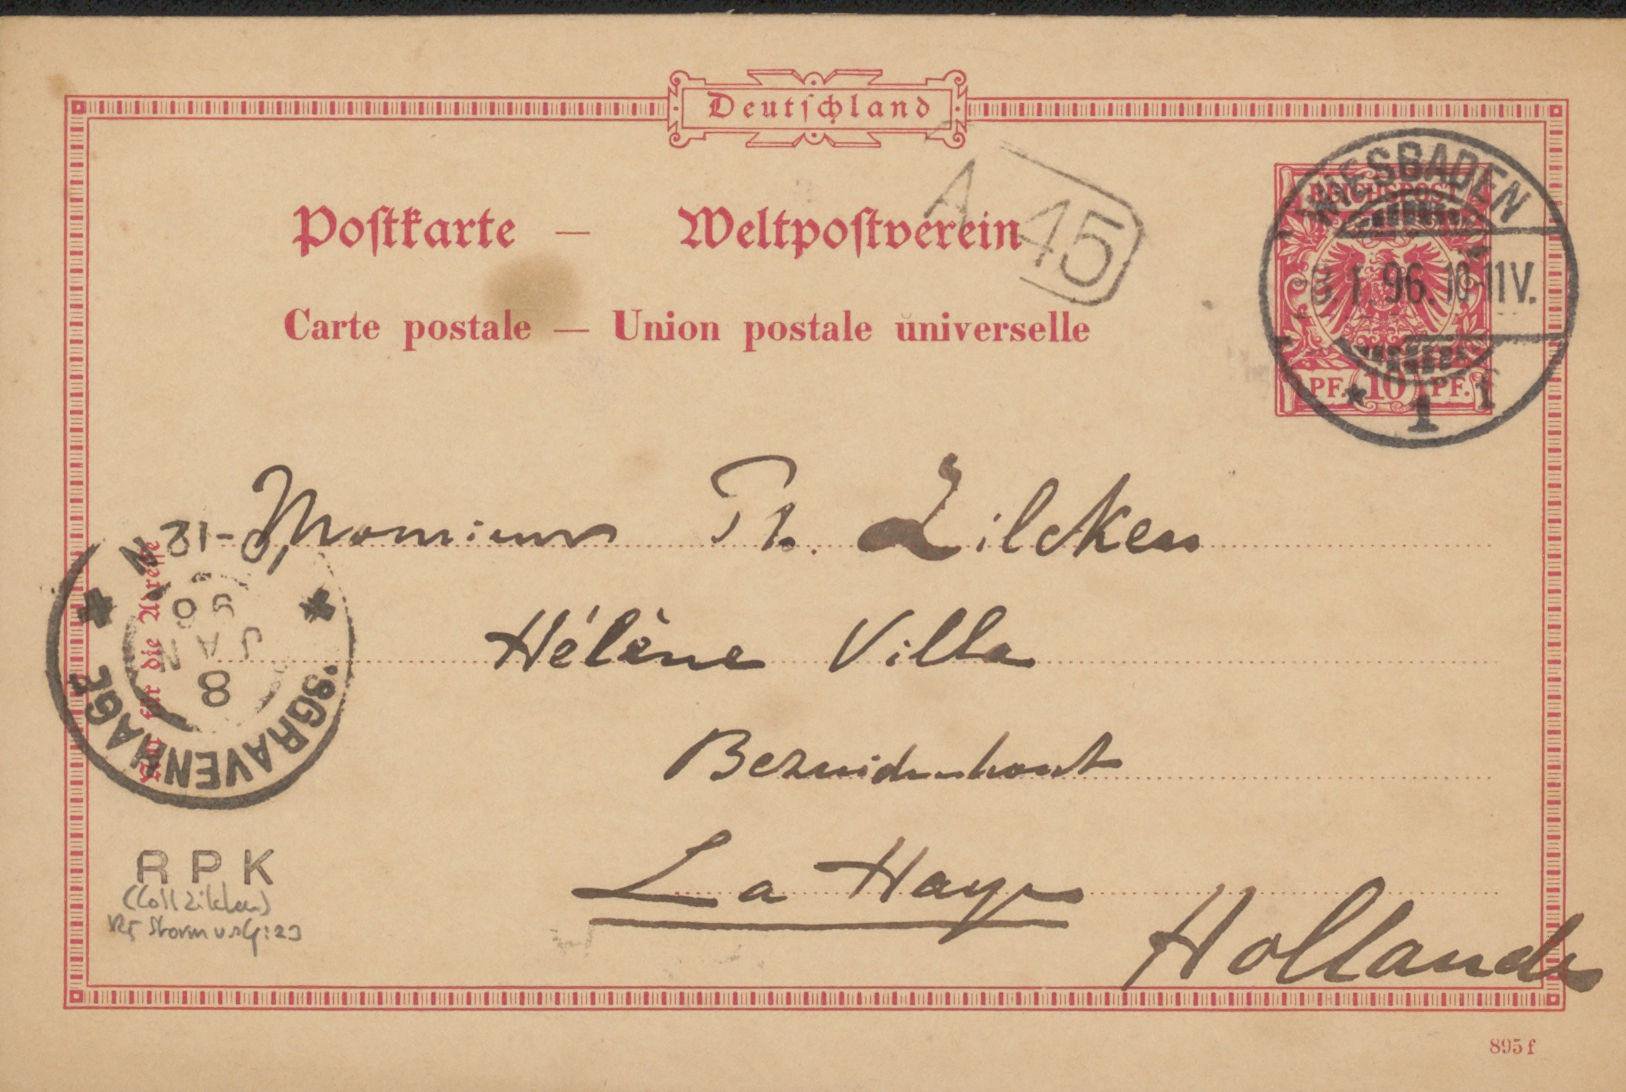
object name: postcard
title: Briefkaart aan Philip Zilcken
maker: carel nicolaas storm van s-gravesande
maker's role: draughtsman, print maker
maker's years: 1841-1924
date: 1896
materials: cardboard, ink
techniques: pen, writing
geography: wiesbaden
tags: painter, philip zilcken, the graphic arts, printed matter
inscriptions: collector's mark: ‘RPK’